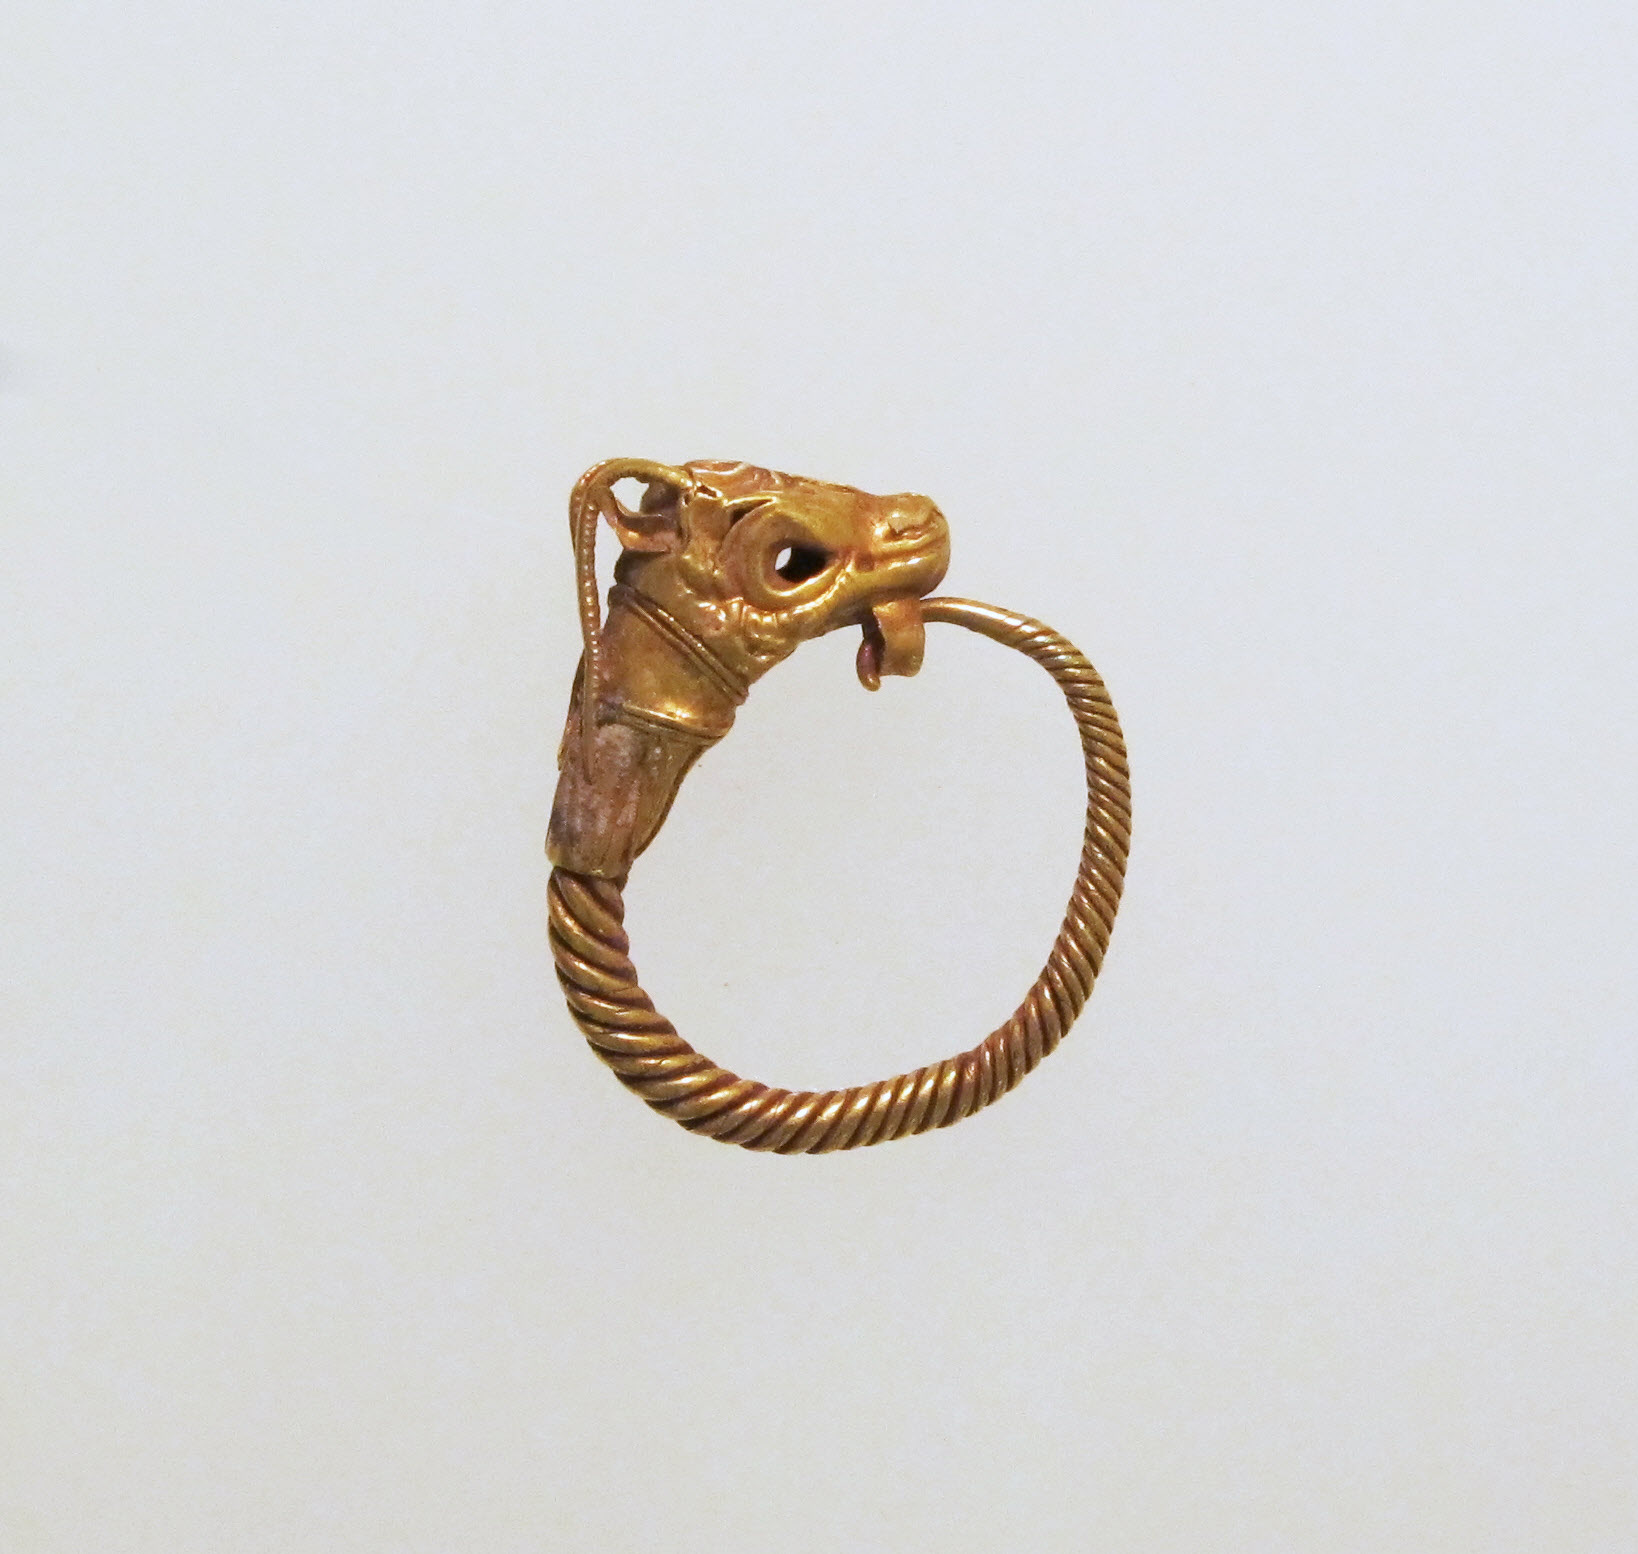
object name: earring with head of goat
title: Gold earring with head of a goat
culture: greek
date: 400-201 BCE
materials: gold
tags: goats